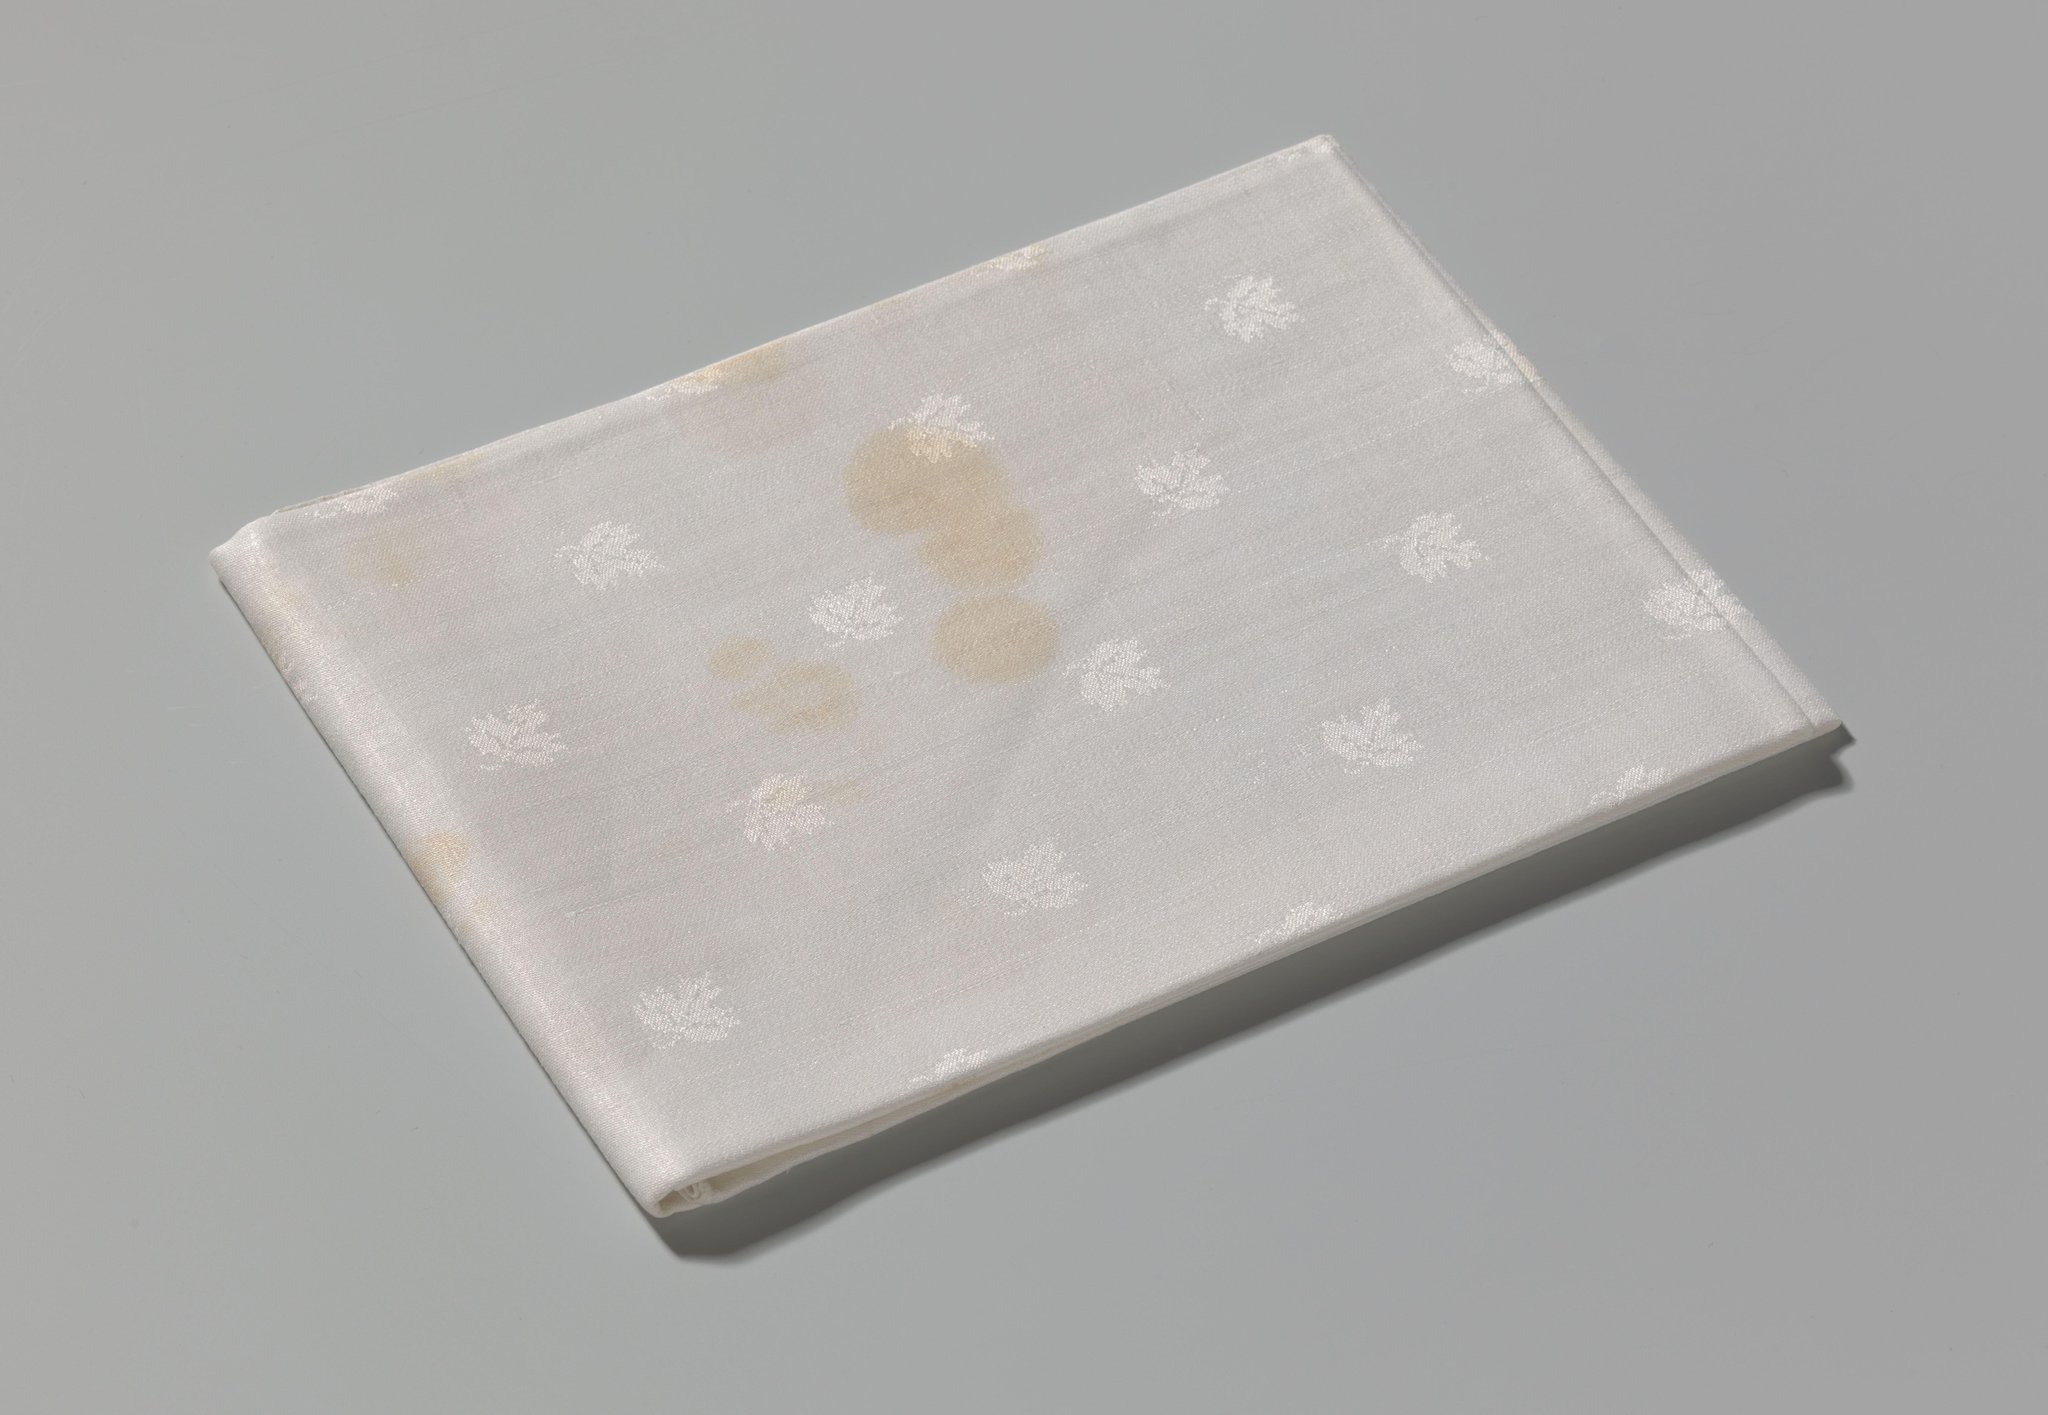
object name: napkin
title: Servet van wit linnendamast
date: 1800-1900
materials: linen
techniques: damask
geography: netherlands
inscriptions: mark: ‘twee palmtakken, waarbinnen de gekroonde initialen CB en 25’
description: Wit linnen damasten servet. Merk twee palmtakken, waarbinnen de gekroonde initialen CB en 25.